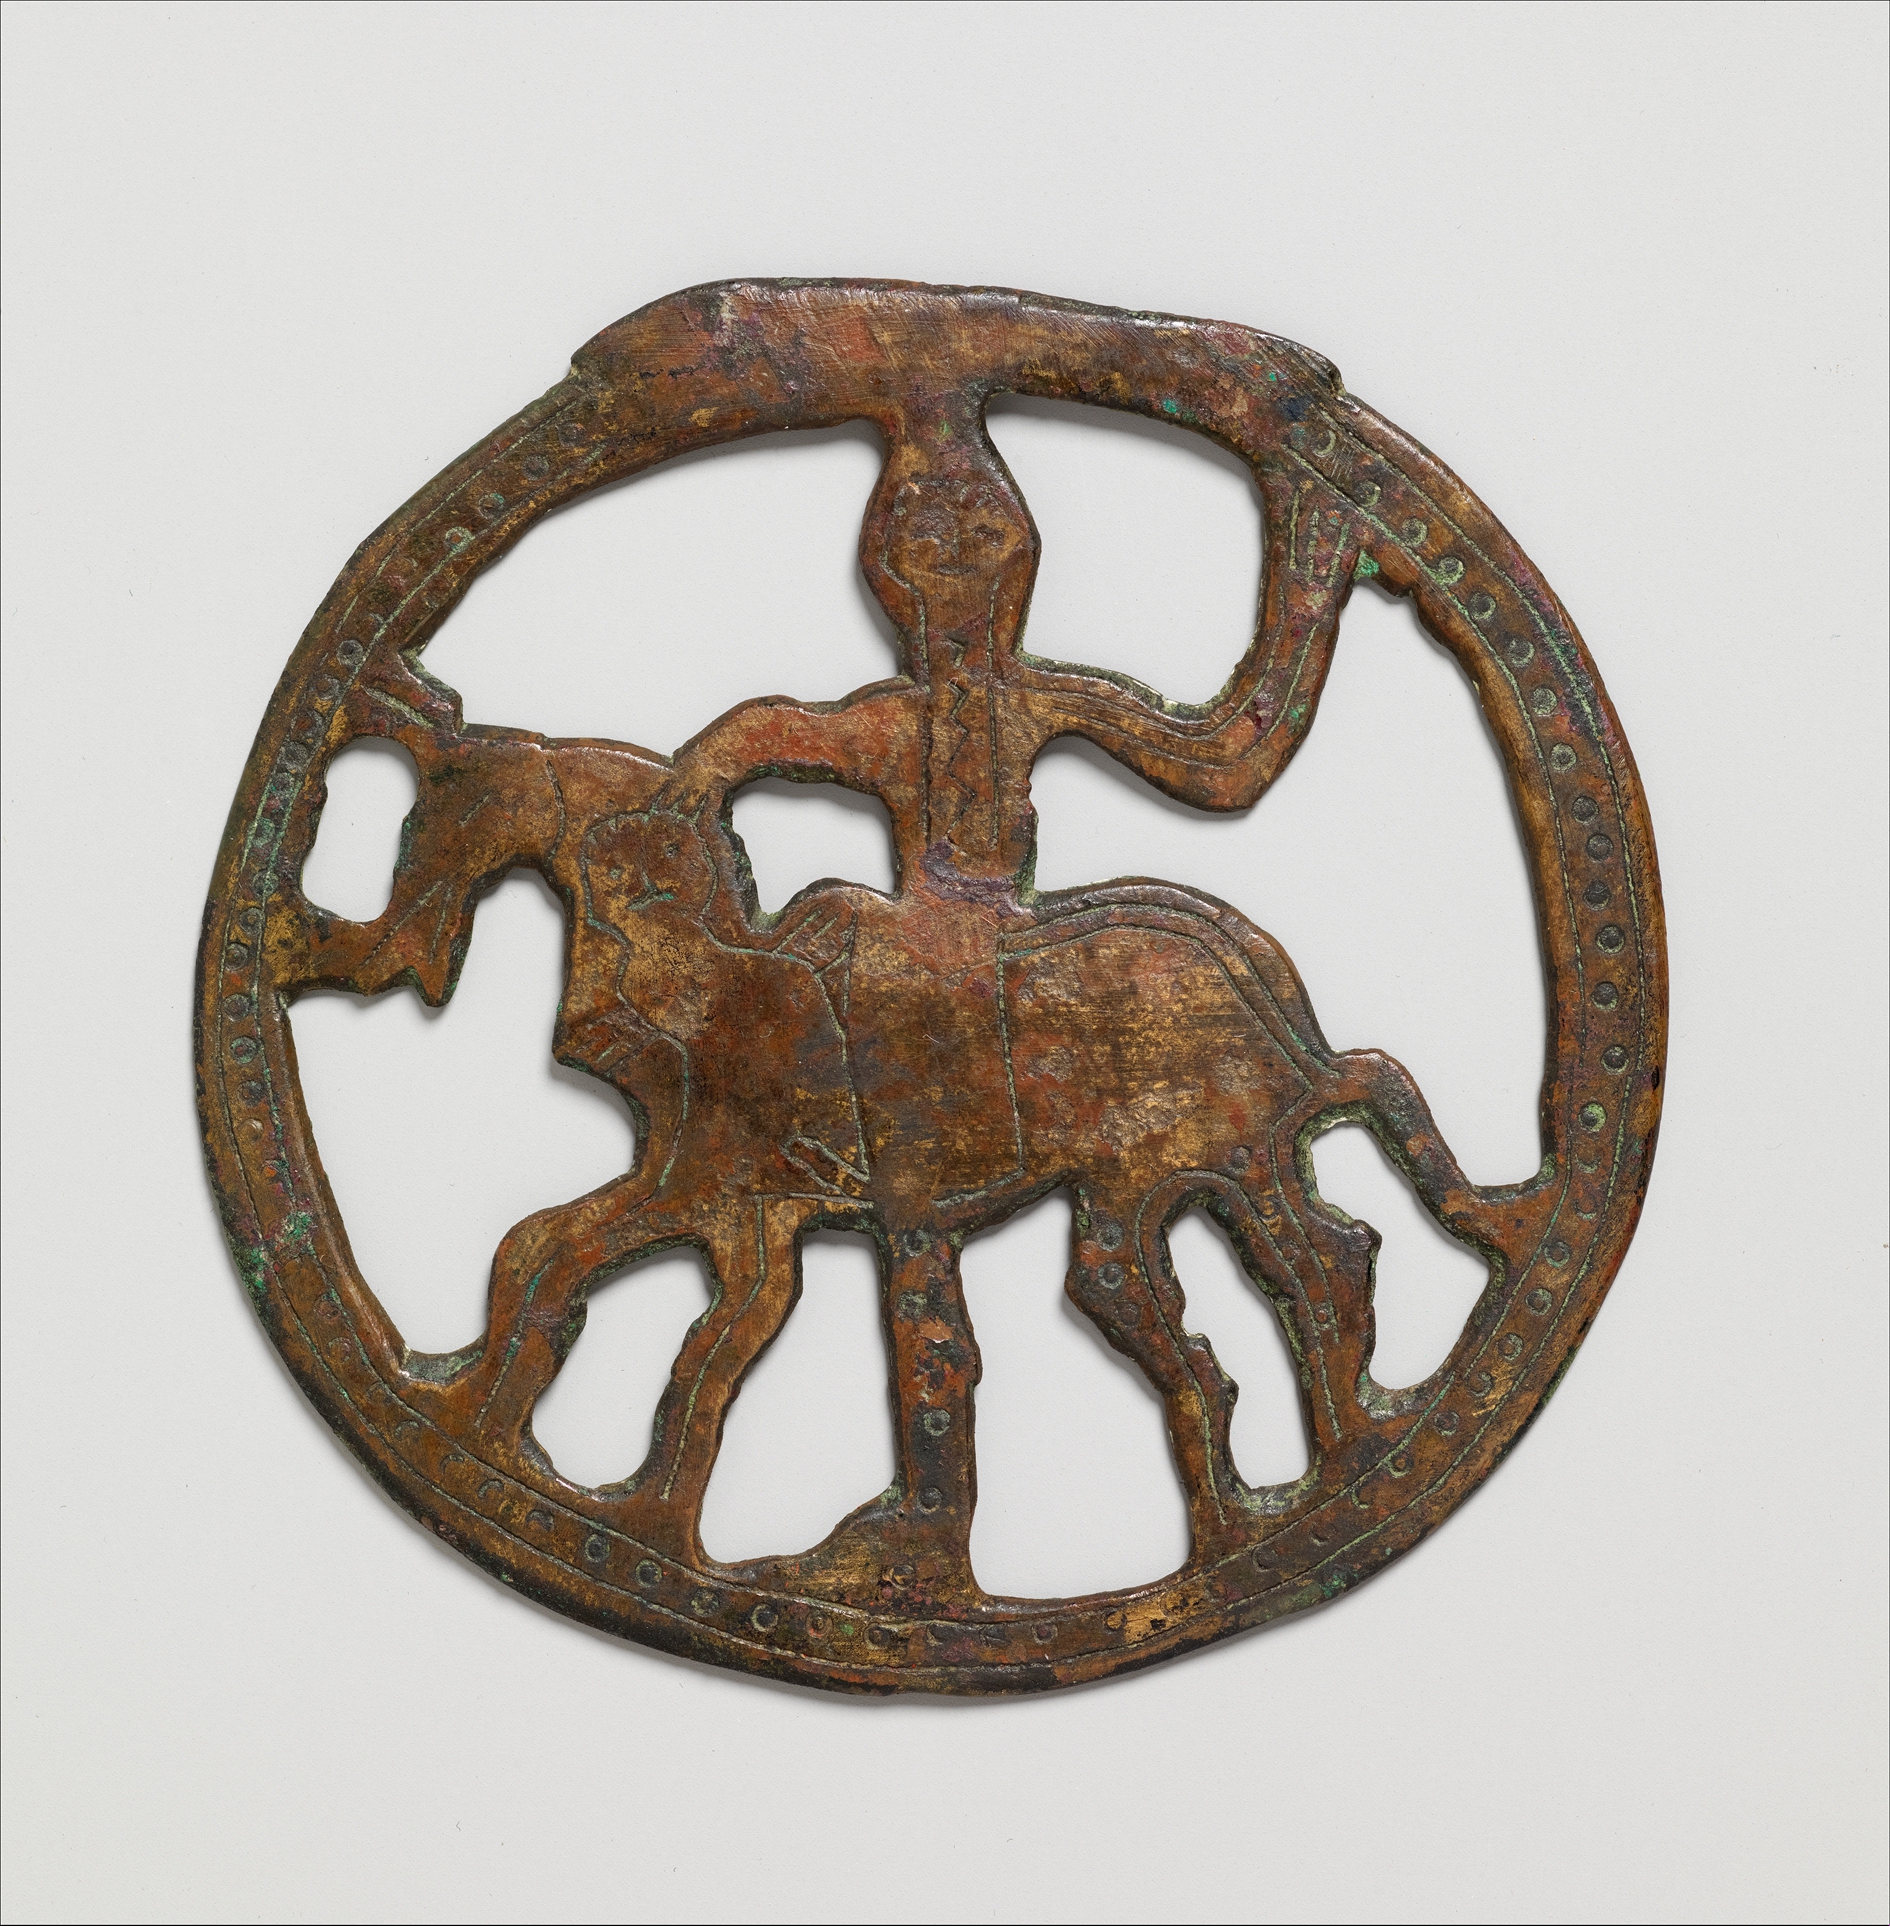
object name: plaque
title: Openwork Belt Fitting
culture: frankish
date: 601-700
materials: copper alloy, gilt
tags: horses